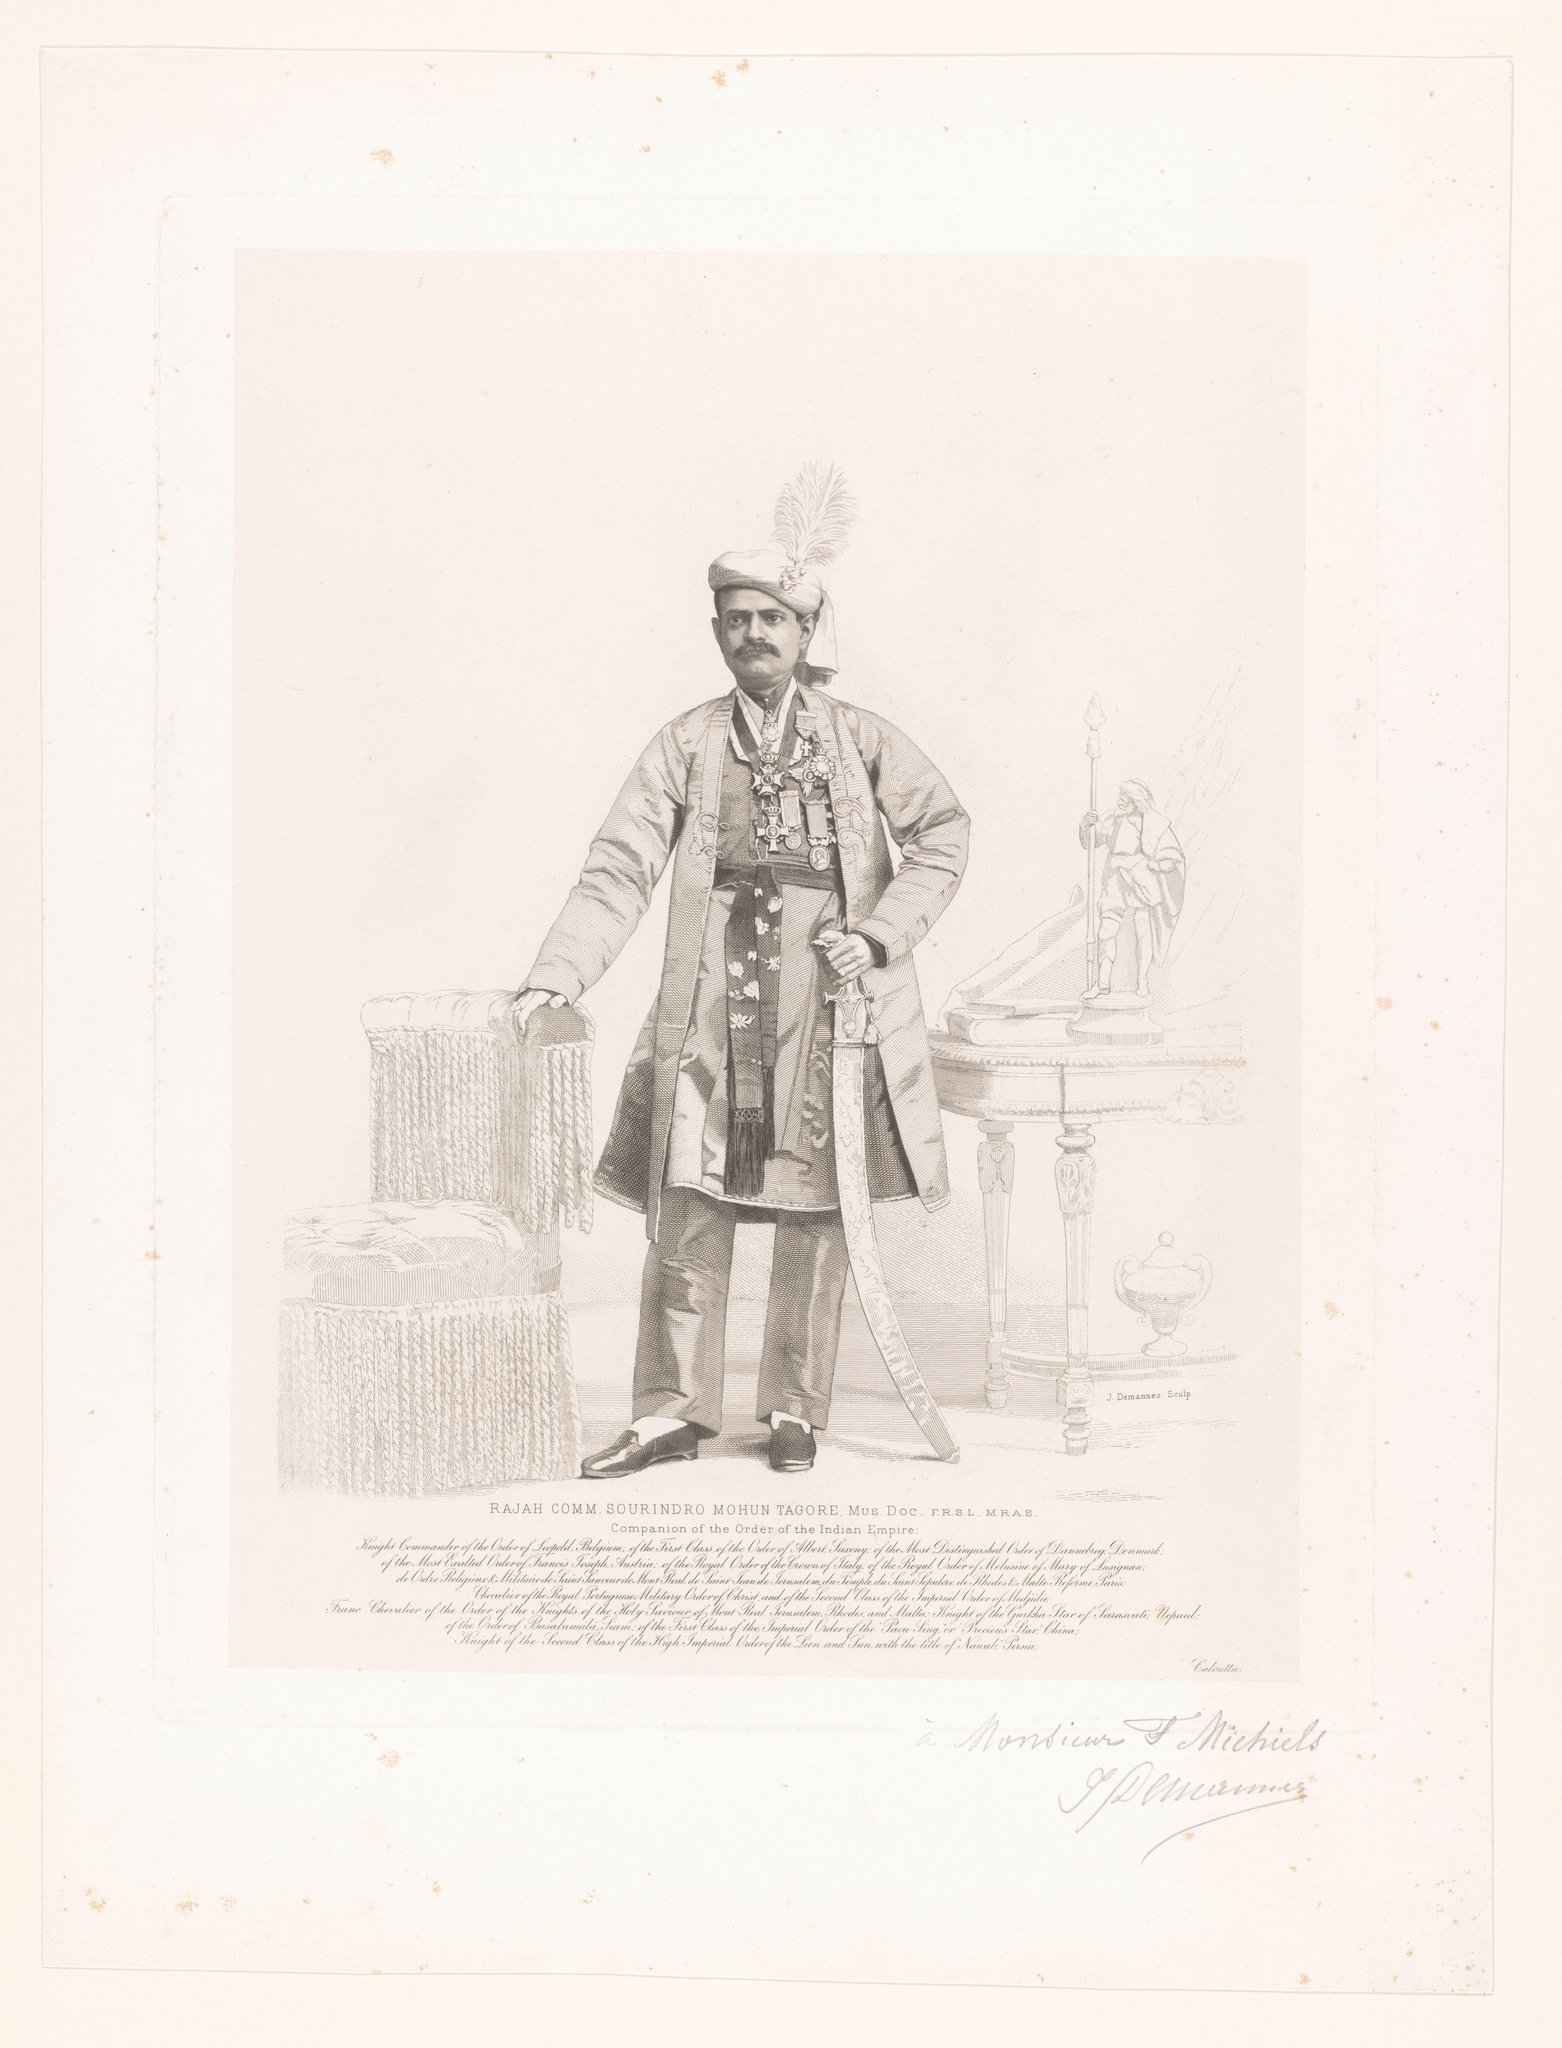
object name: print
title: Portret van Raja Sourindro Mohun Tagore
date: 1855-1902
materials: paper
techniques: engraving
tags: standing figure (+ front view), historical persons, table, sculpture, chair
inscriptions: collector's mark: Lugt 2228